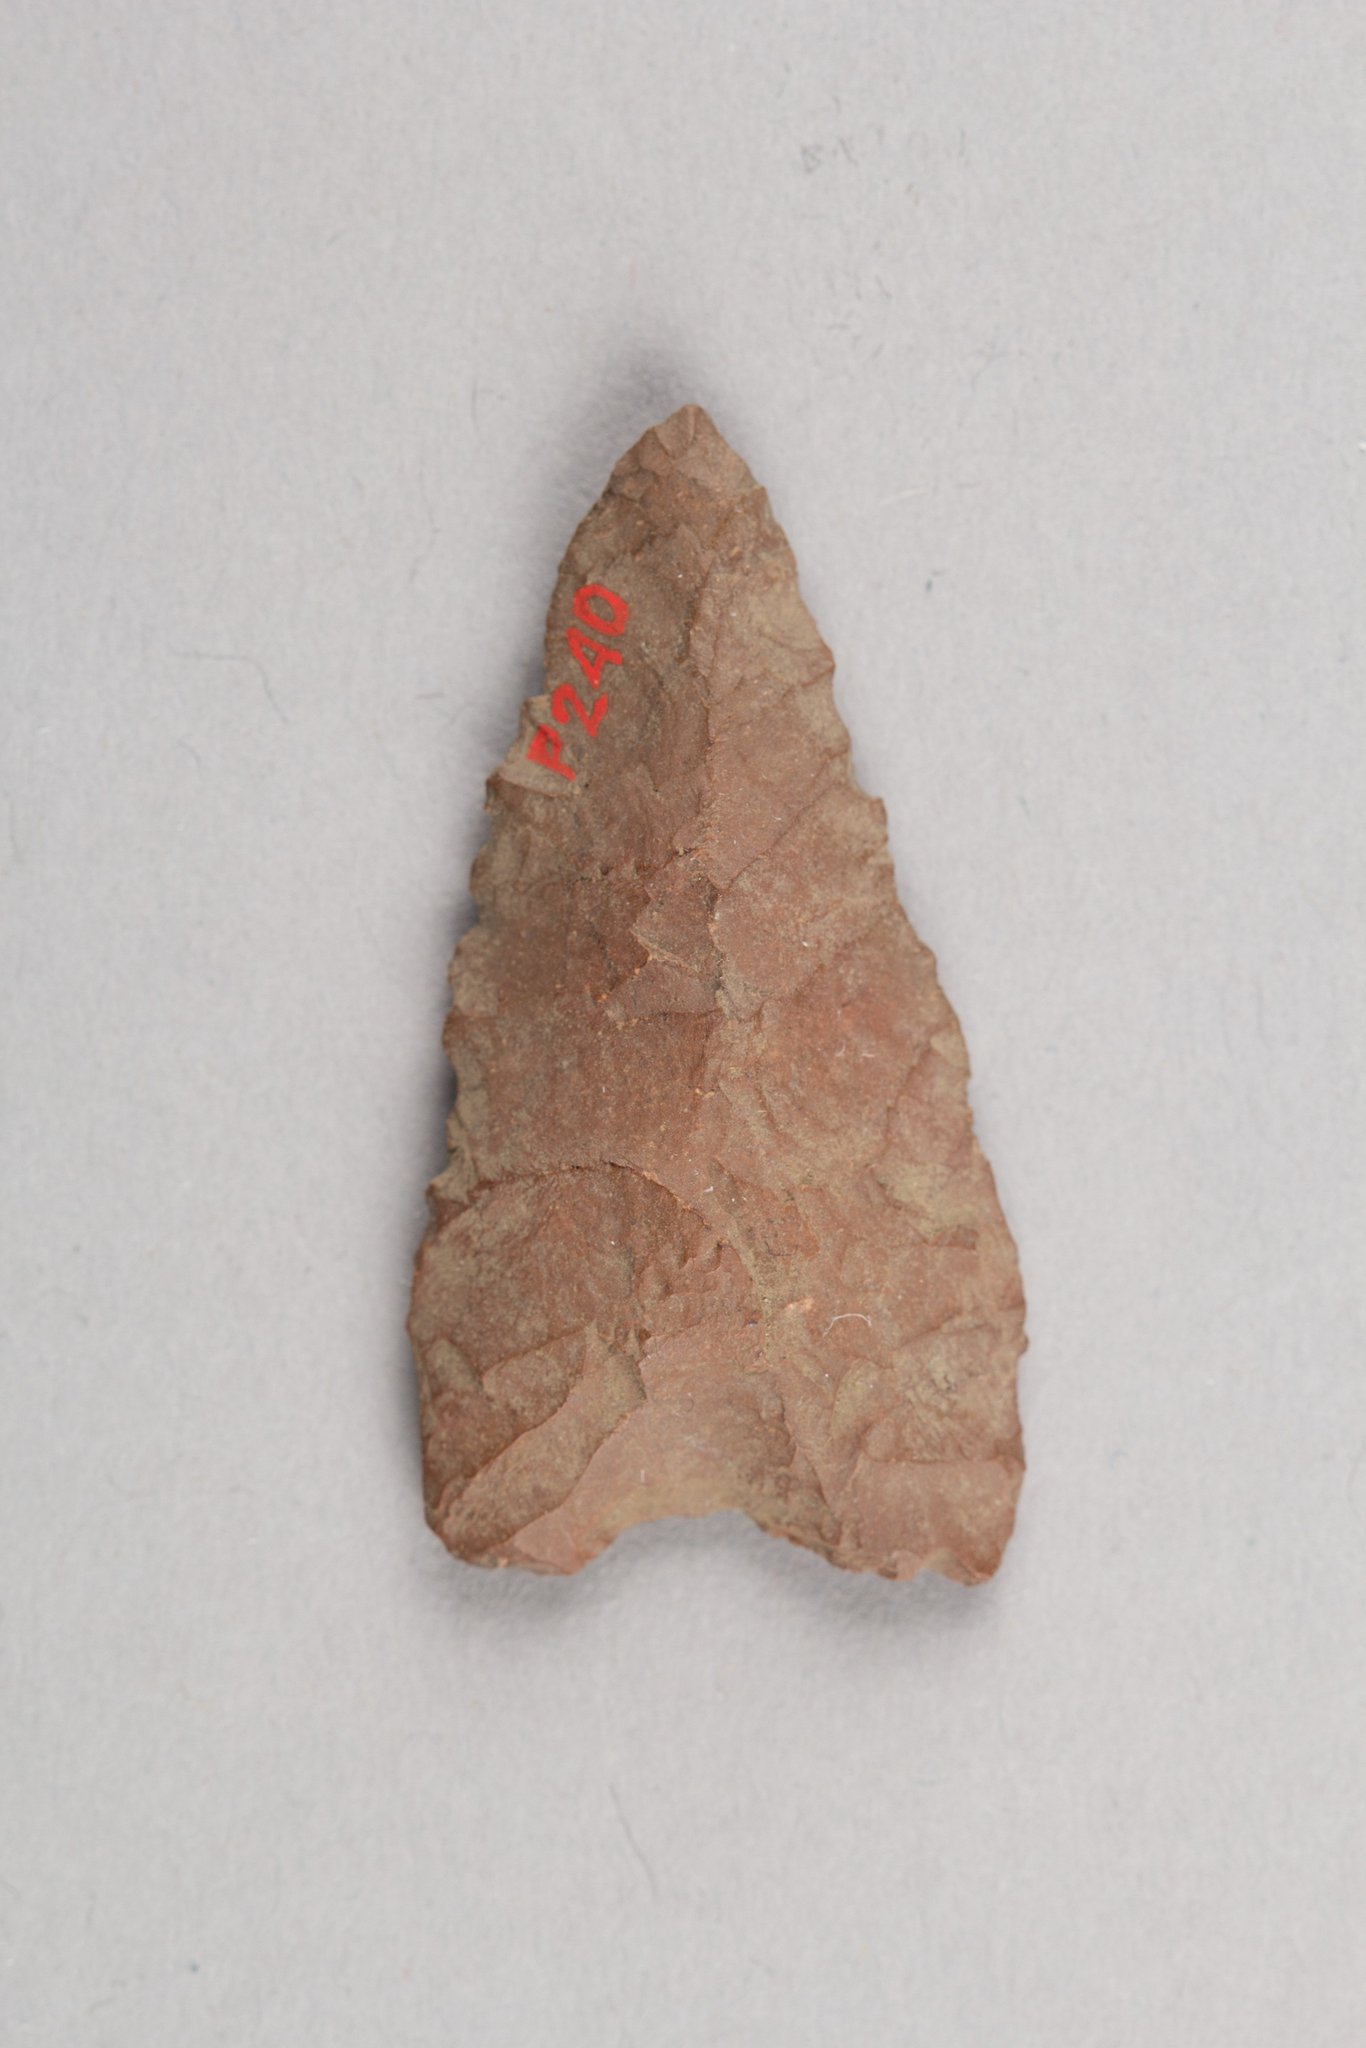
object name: arrowhead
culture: japanese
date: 1500-1000 BCE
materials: stone